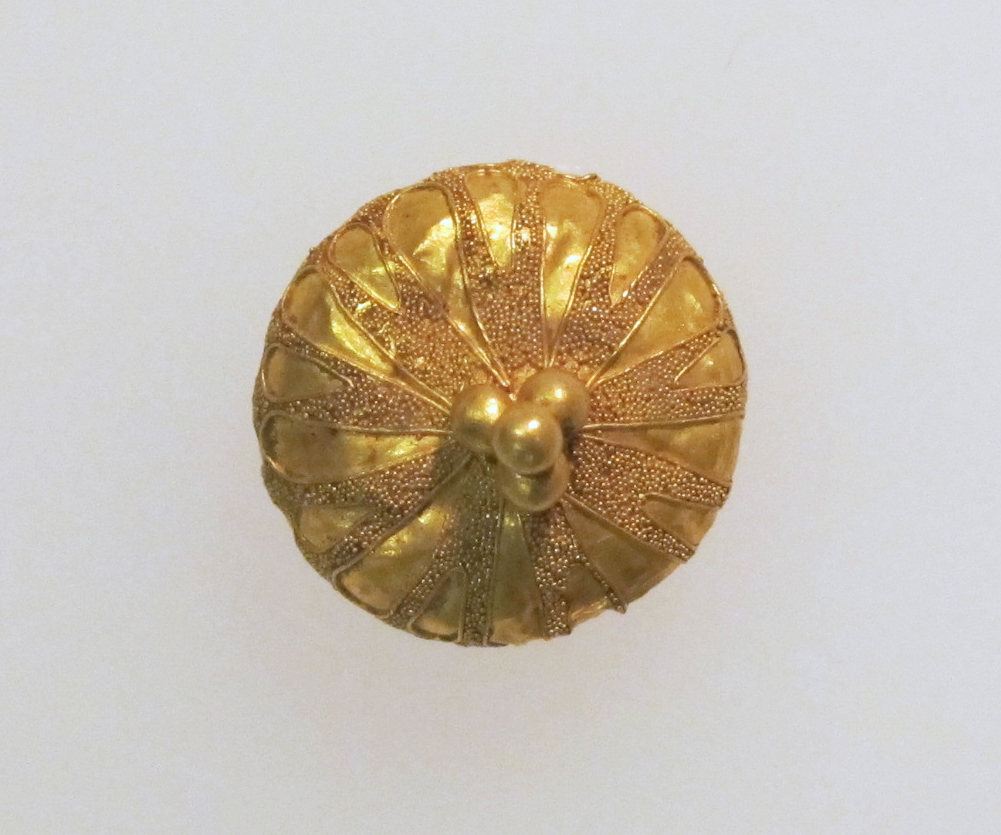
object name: stylus or pin head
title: Stylus or pin head ?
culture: etruscan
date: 700-401 BCE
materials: gold